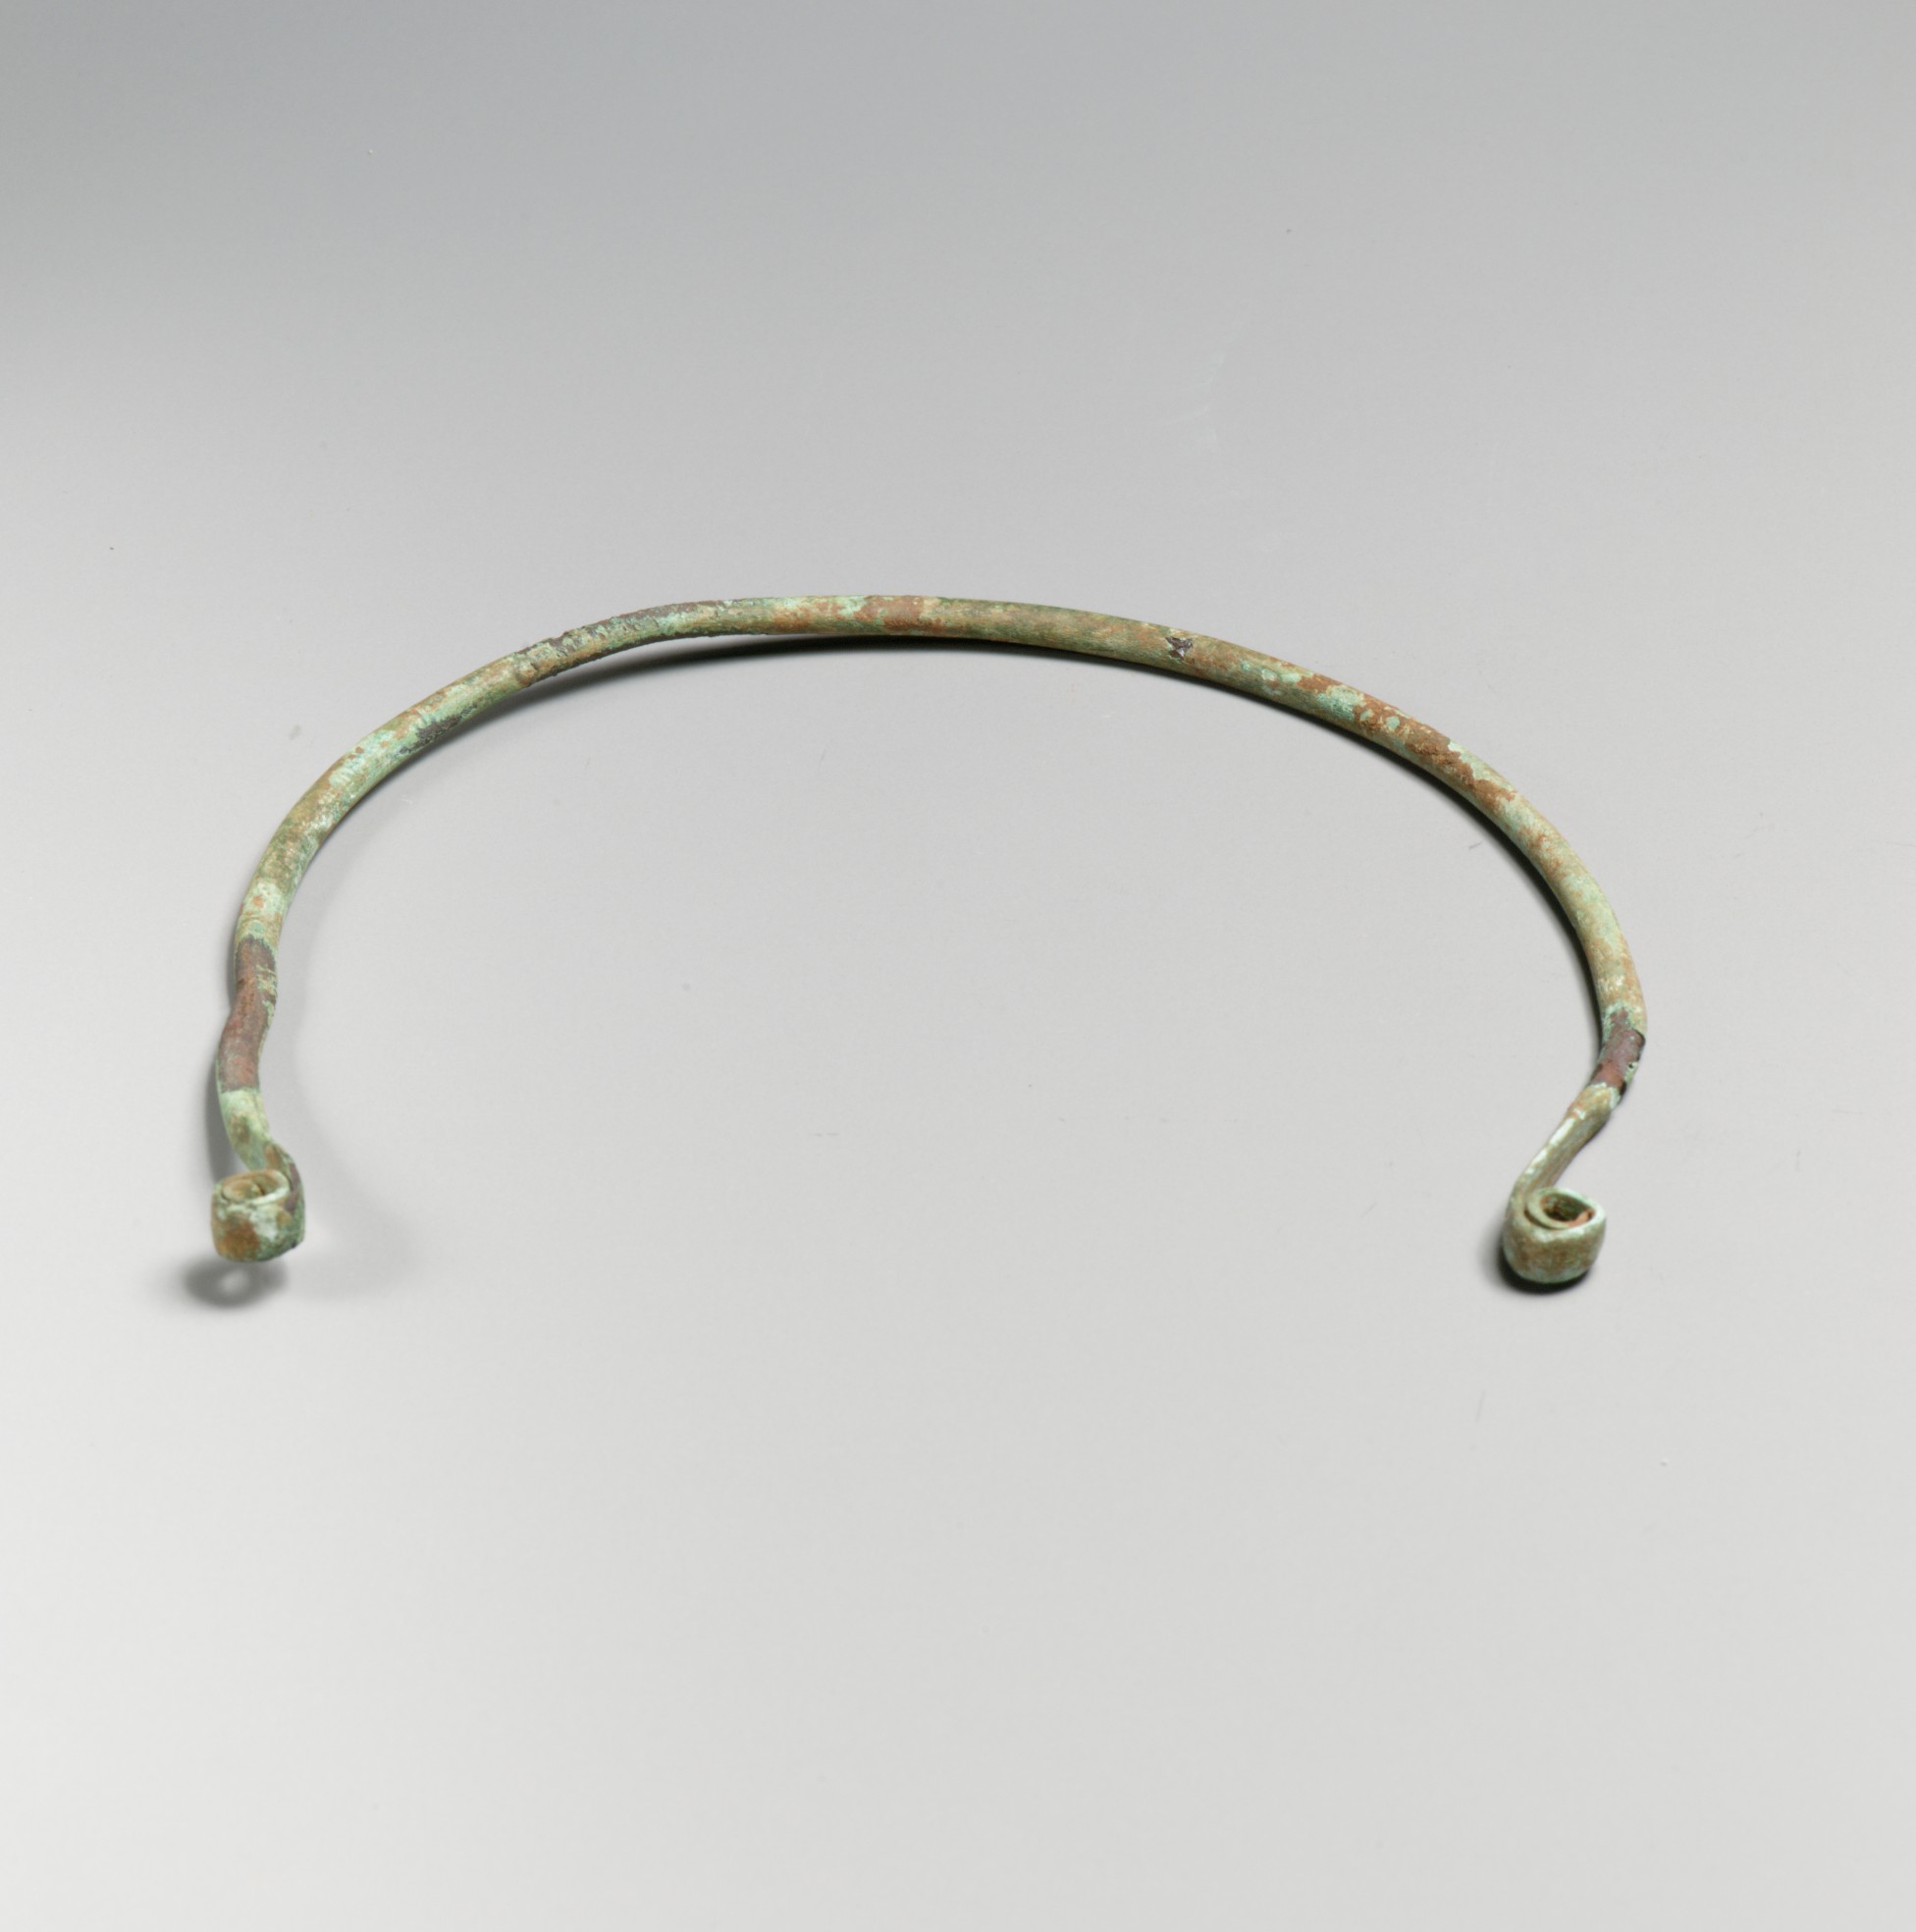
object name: necklace, torque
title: Necklace or Torque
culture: italic, villanovan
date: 900-701 BCE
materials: bronze